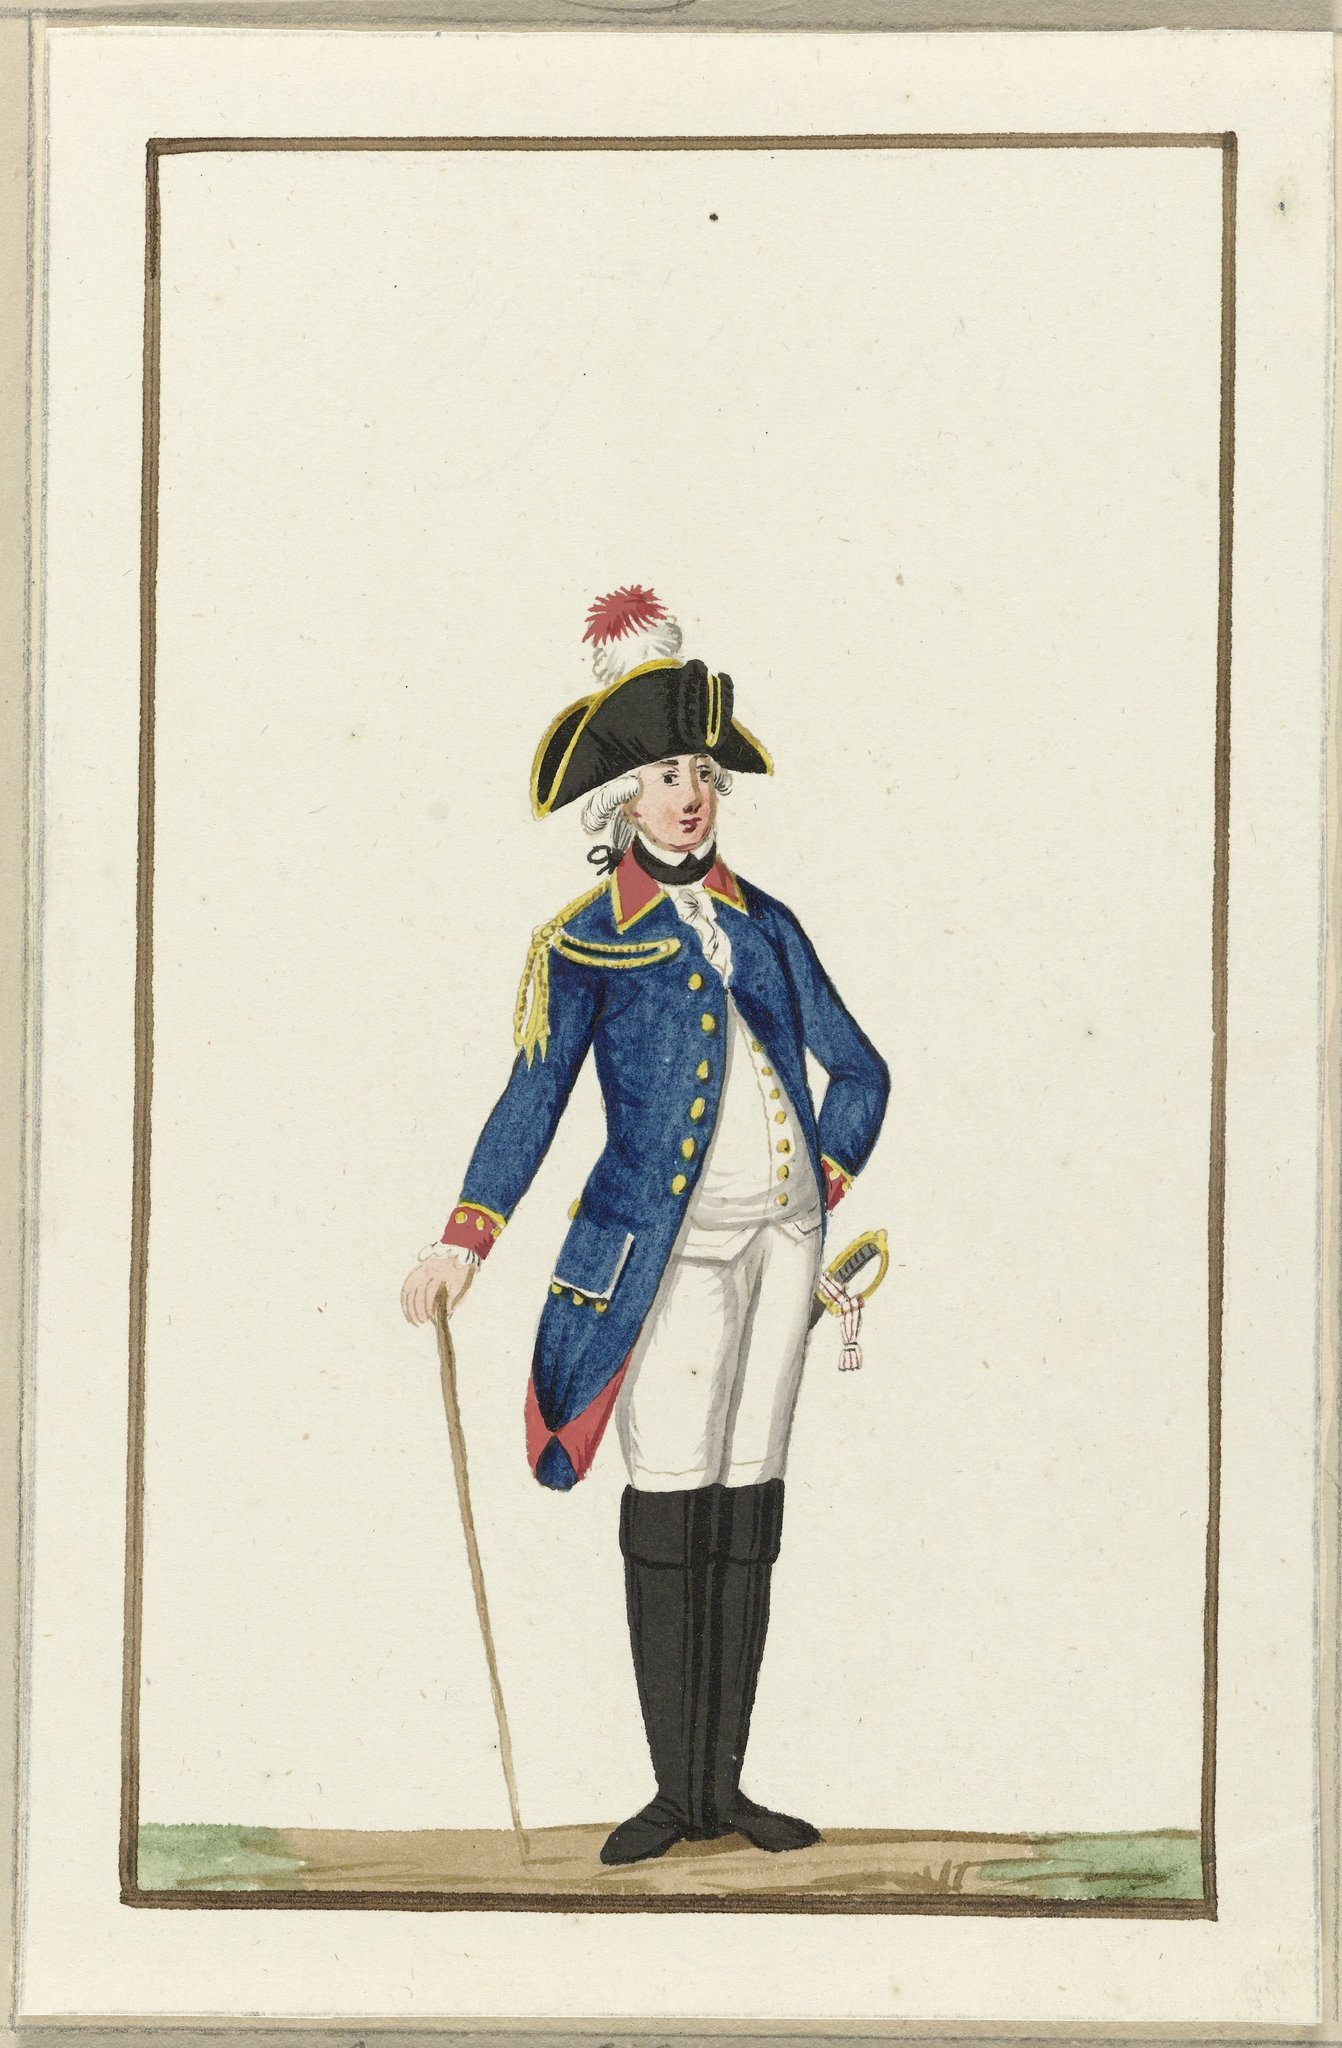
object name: costume print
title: Montering van de Utrechtse artillerie, ca. 1787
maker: Anonymous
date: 1787-1790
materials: paper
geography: northern netherlands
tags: (military) uniforms (+ citizen soldiery, civil guard, citizen militia), utrecht, patriots (1780-1795)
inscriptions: collector's mark: Lugt 2228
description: Uniform van de artillerie van Utrecht. Onderdeel van een serie van 32 tekeningen van de verschillende monteringen (uniformen) van patriotse schutterijen en burgerkorpsen in Nederland in 1787.